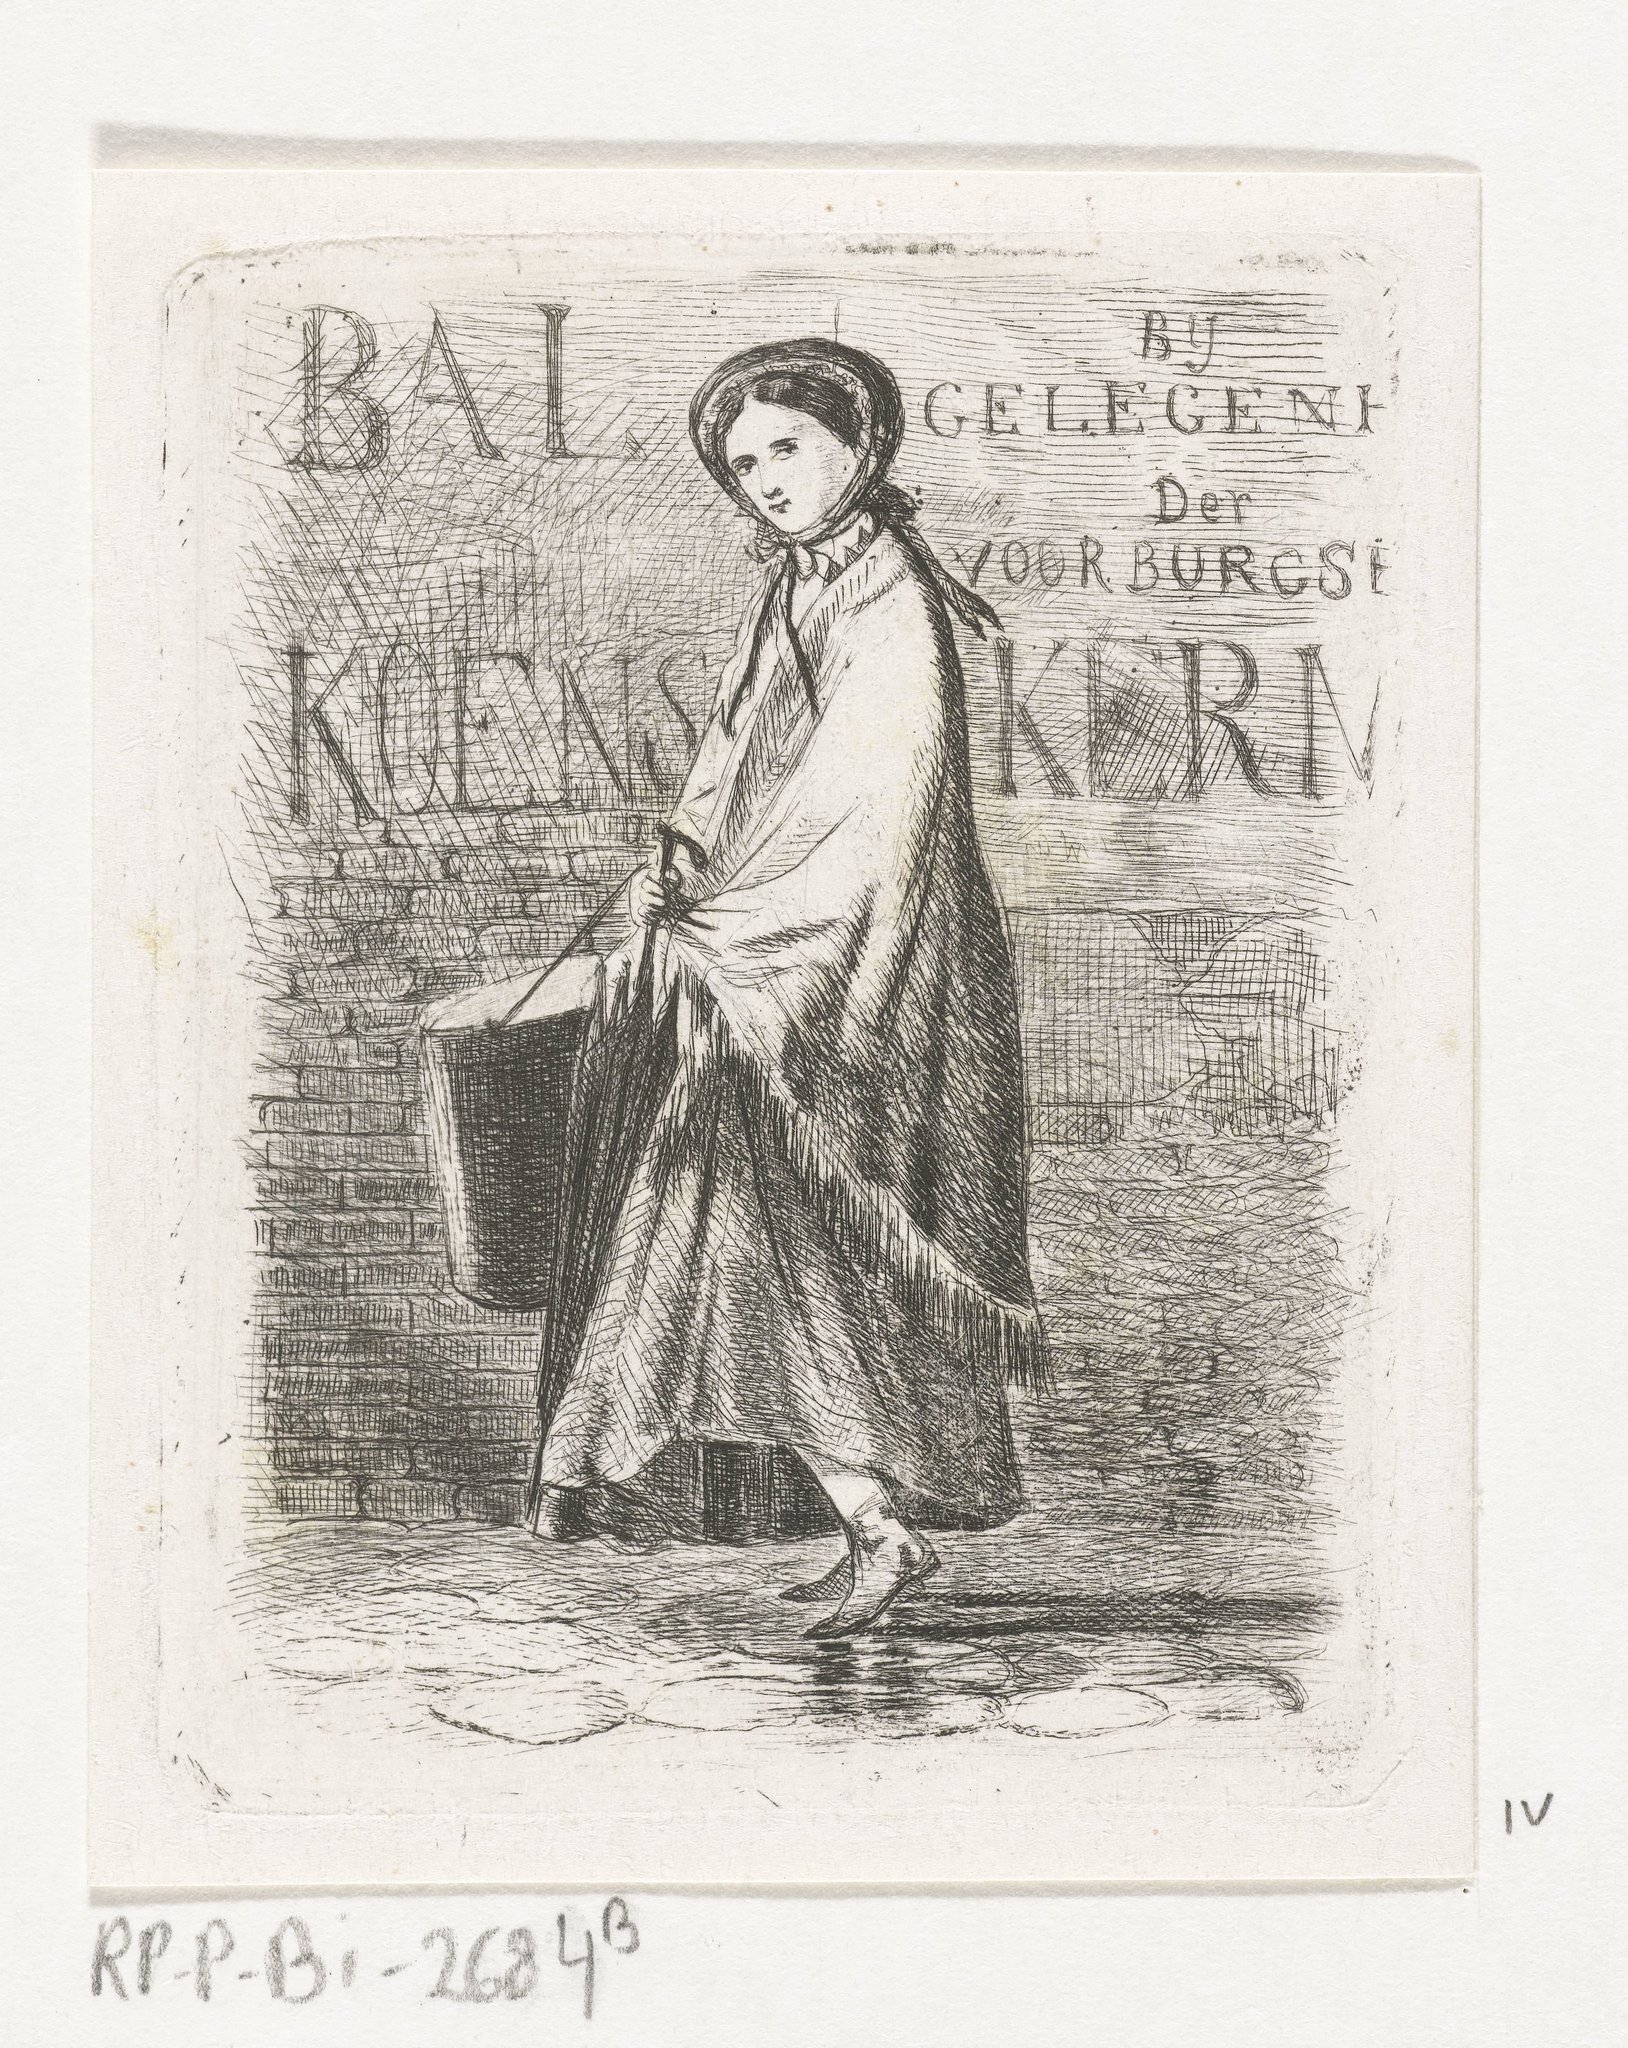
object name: print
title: Vrouw met hoedendoos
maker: karel frederik bombled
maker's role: draughtsman, print maker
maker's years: 1822-1902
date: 1832-1902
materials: paper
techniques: drypoint, etching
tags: container of paper, cardboard: bag, carton, umbrella, standing figure (canon, proportions), the (nude) human figure; 'corpo humano' (ripa) (+ young female (human being)), poster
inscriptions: collector's mark: Lugt 2228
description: Een jonge vrouw in 19de eeuwse kleding met hoed en mantel wandelt over straat. Ze heeft een hoedendoos en een paraplu bij zich. Achter haar aan de muur hangen Nederlandse reclameposters.